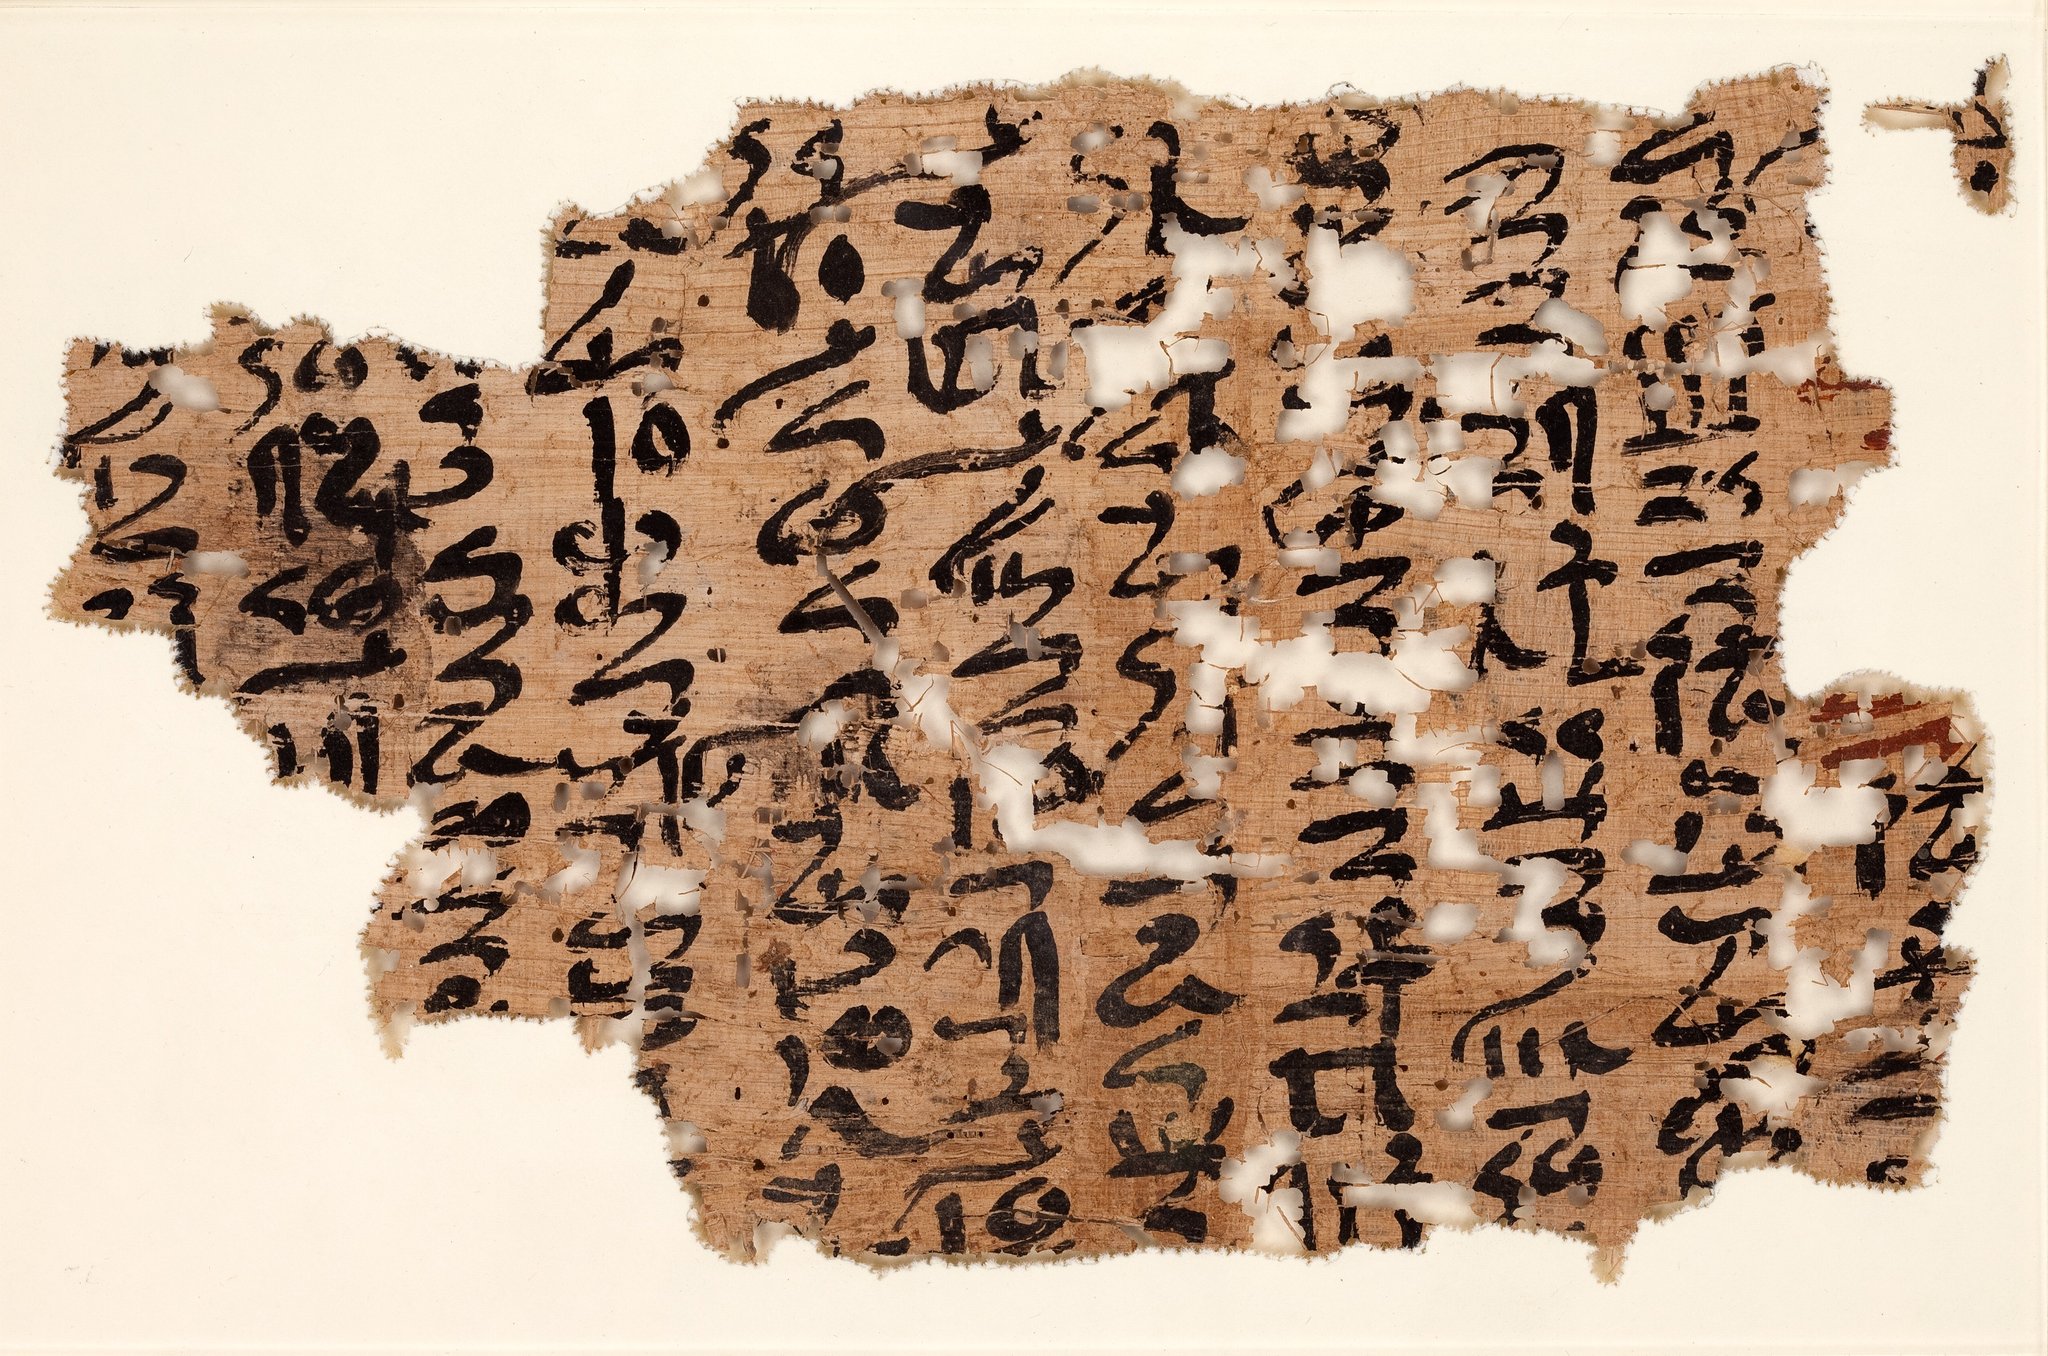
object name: papyrus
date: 2030-1640 BCE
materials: ink, papyrus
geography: egypt